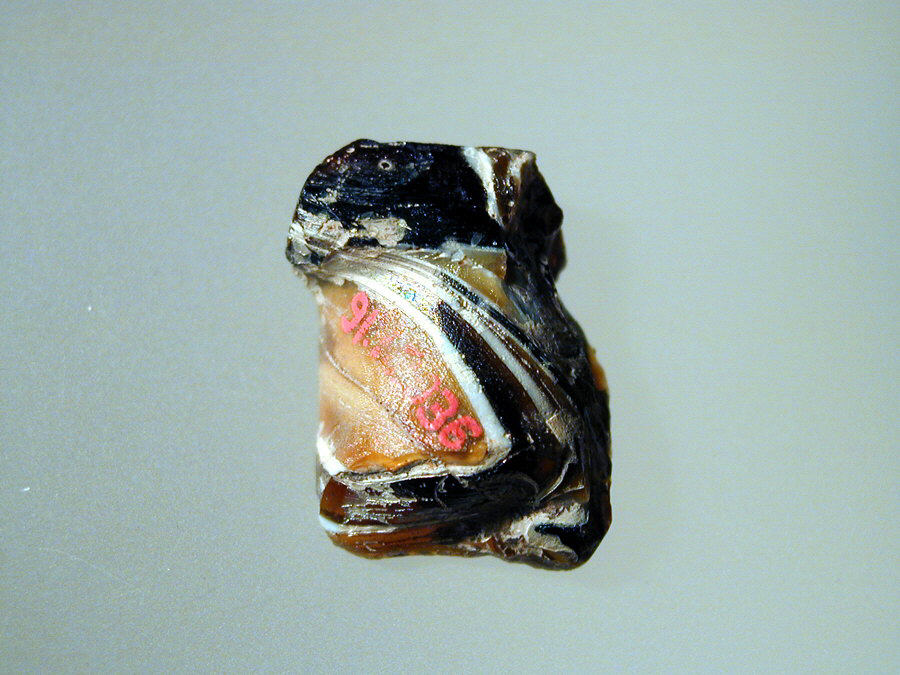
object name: fragment, mosaic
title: Glass mosaic fragment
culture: roman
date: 34 BCE-33 CE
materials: glass